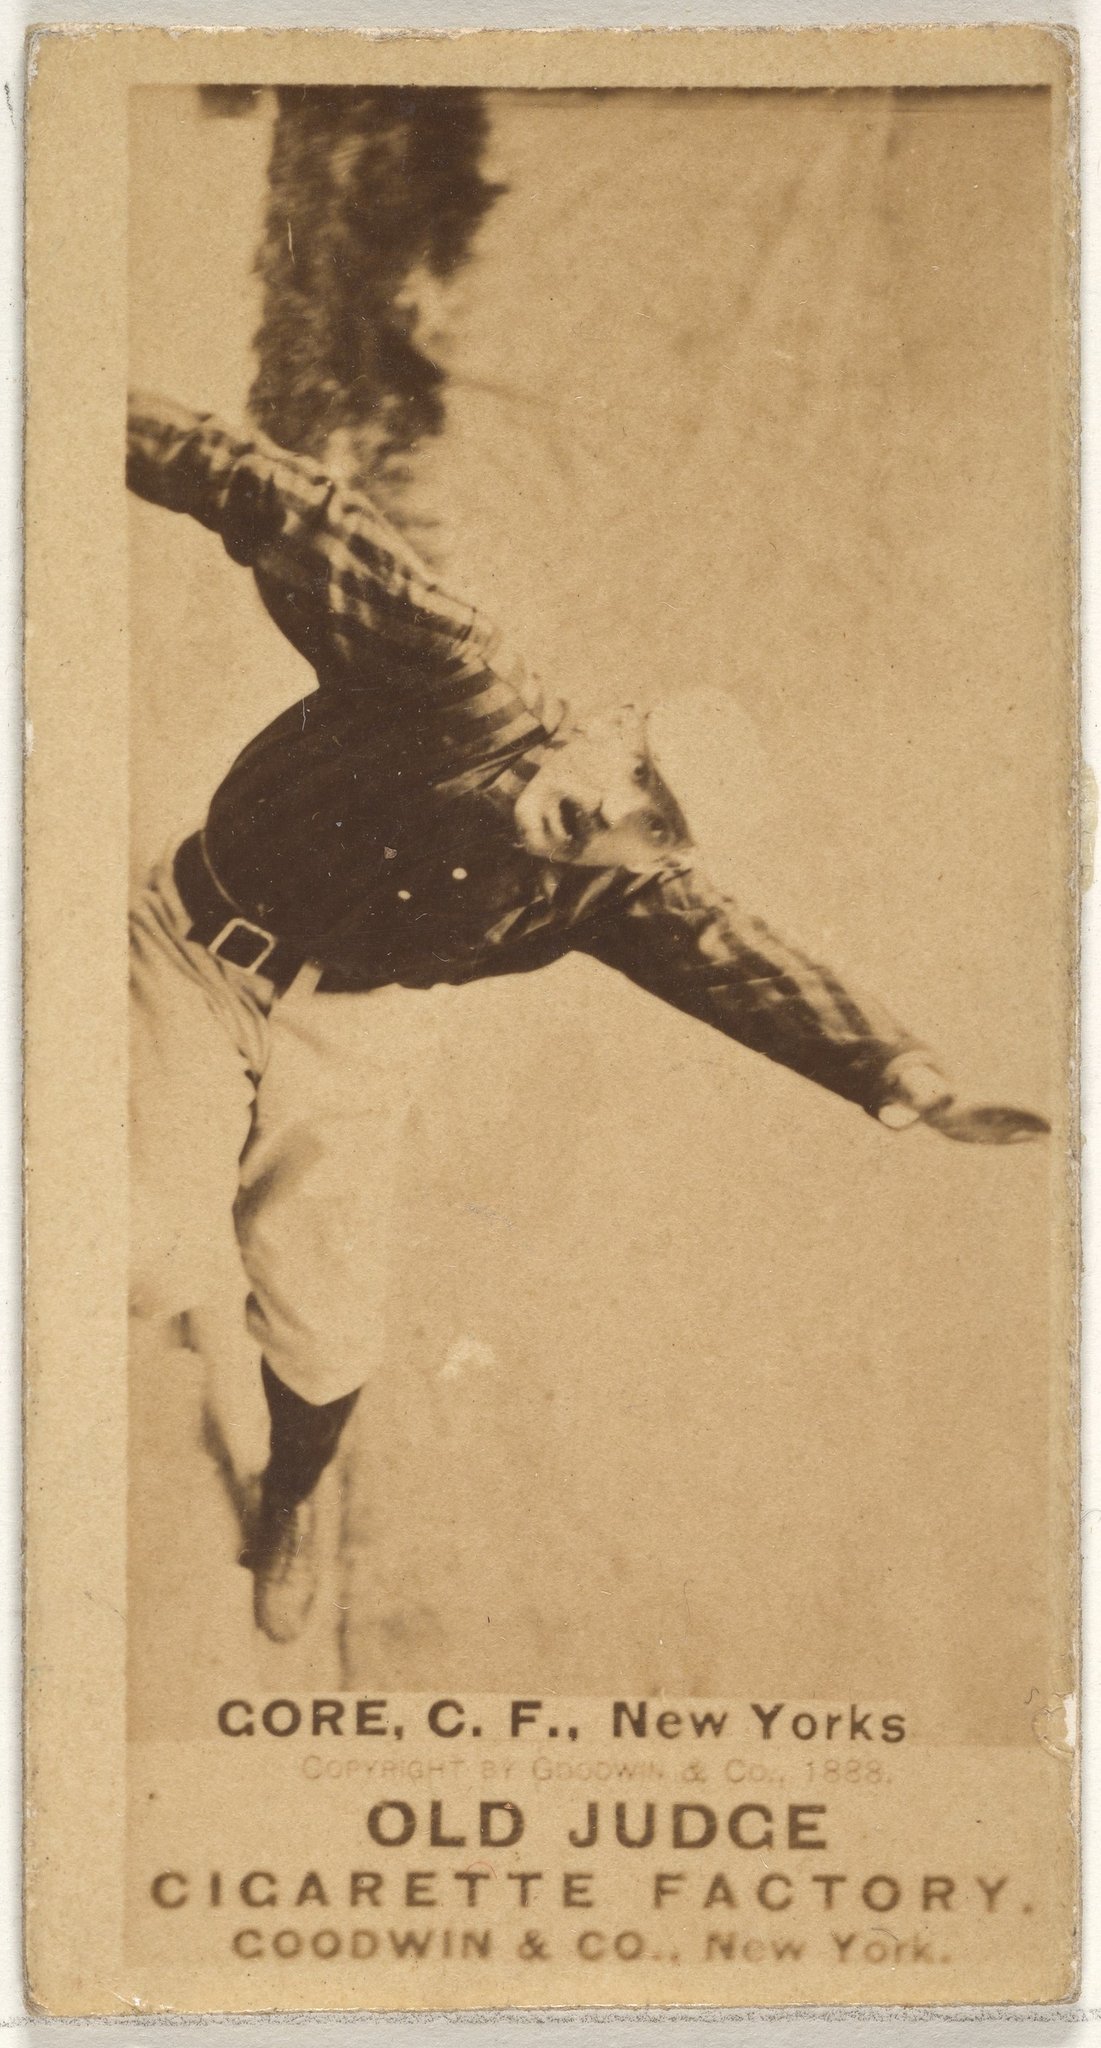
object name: baseball card, photograph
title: George F. "Piano Legs" Gore, Center Field, New York, from the Old Judge series (N172) for Old Judge Cigarettes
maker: goodwin & company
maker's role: publisher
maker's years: 1850-1950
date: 1888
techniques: albumen silver print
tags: men,portraits,baseball,athletes